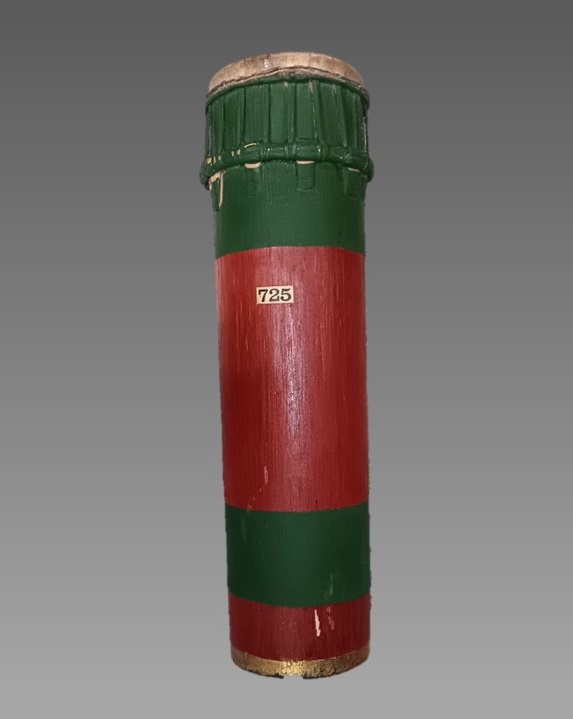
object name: dogdog lojor anak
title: Dogdog lojor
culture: javanese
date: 1867-1900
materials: fiber, wood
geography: indonesia